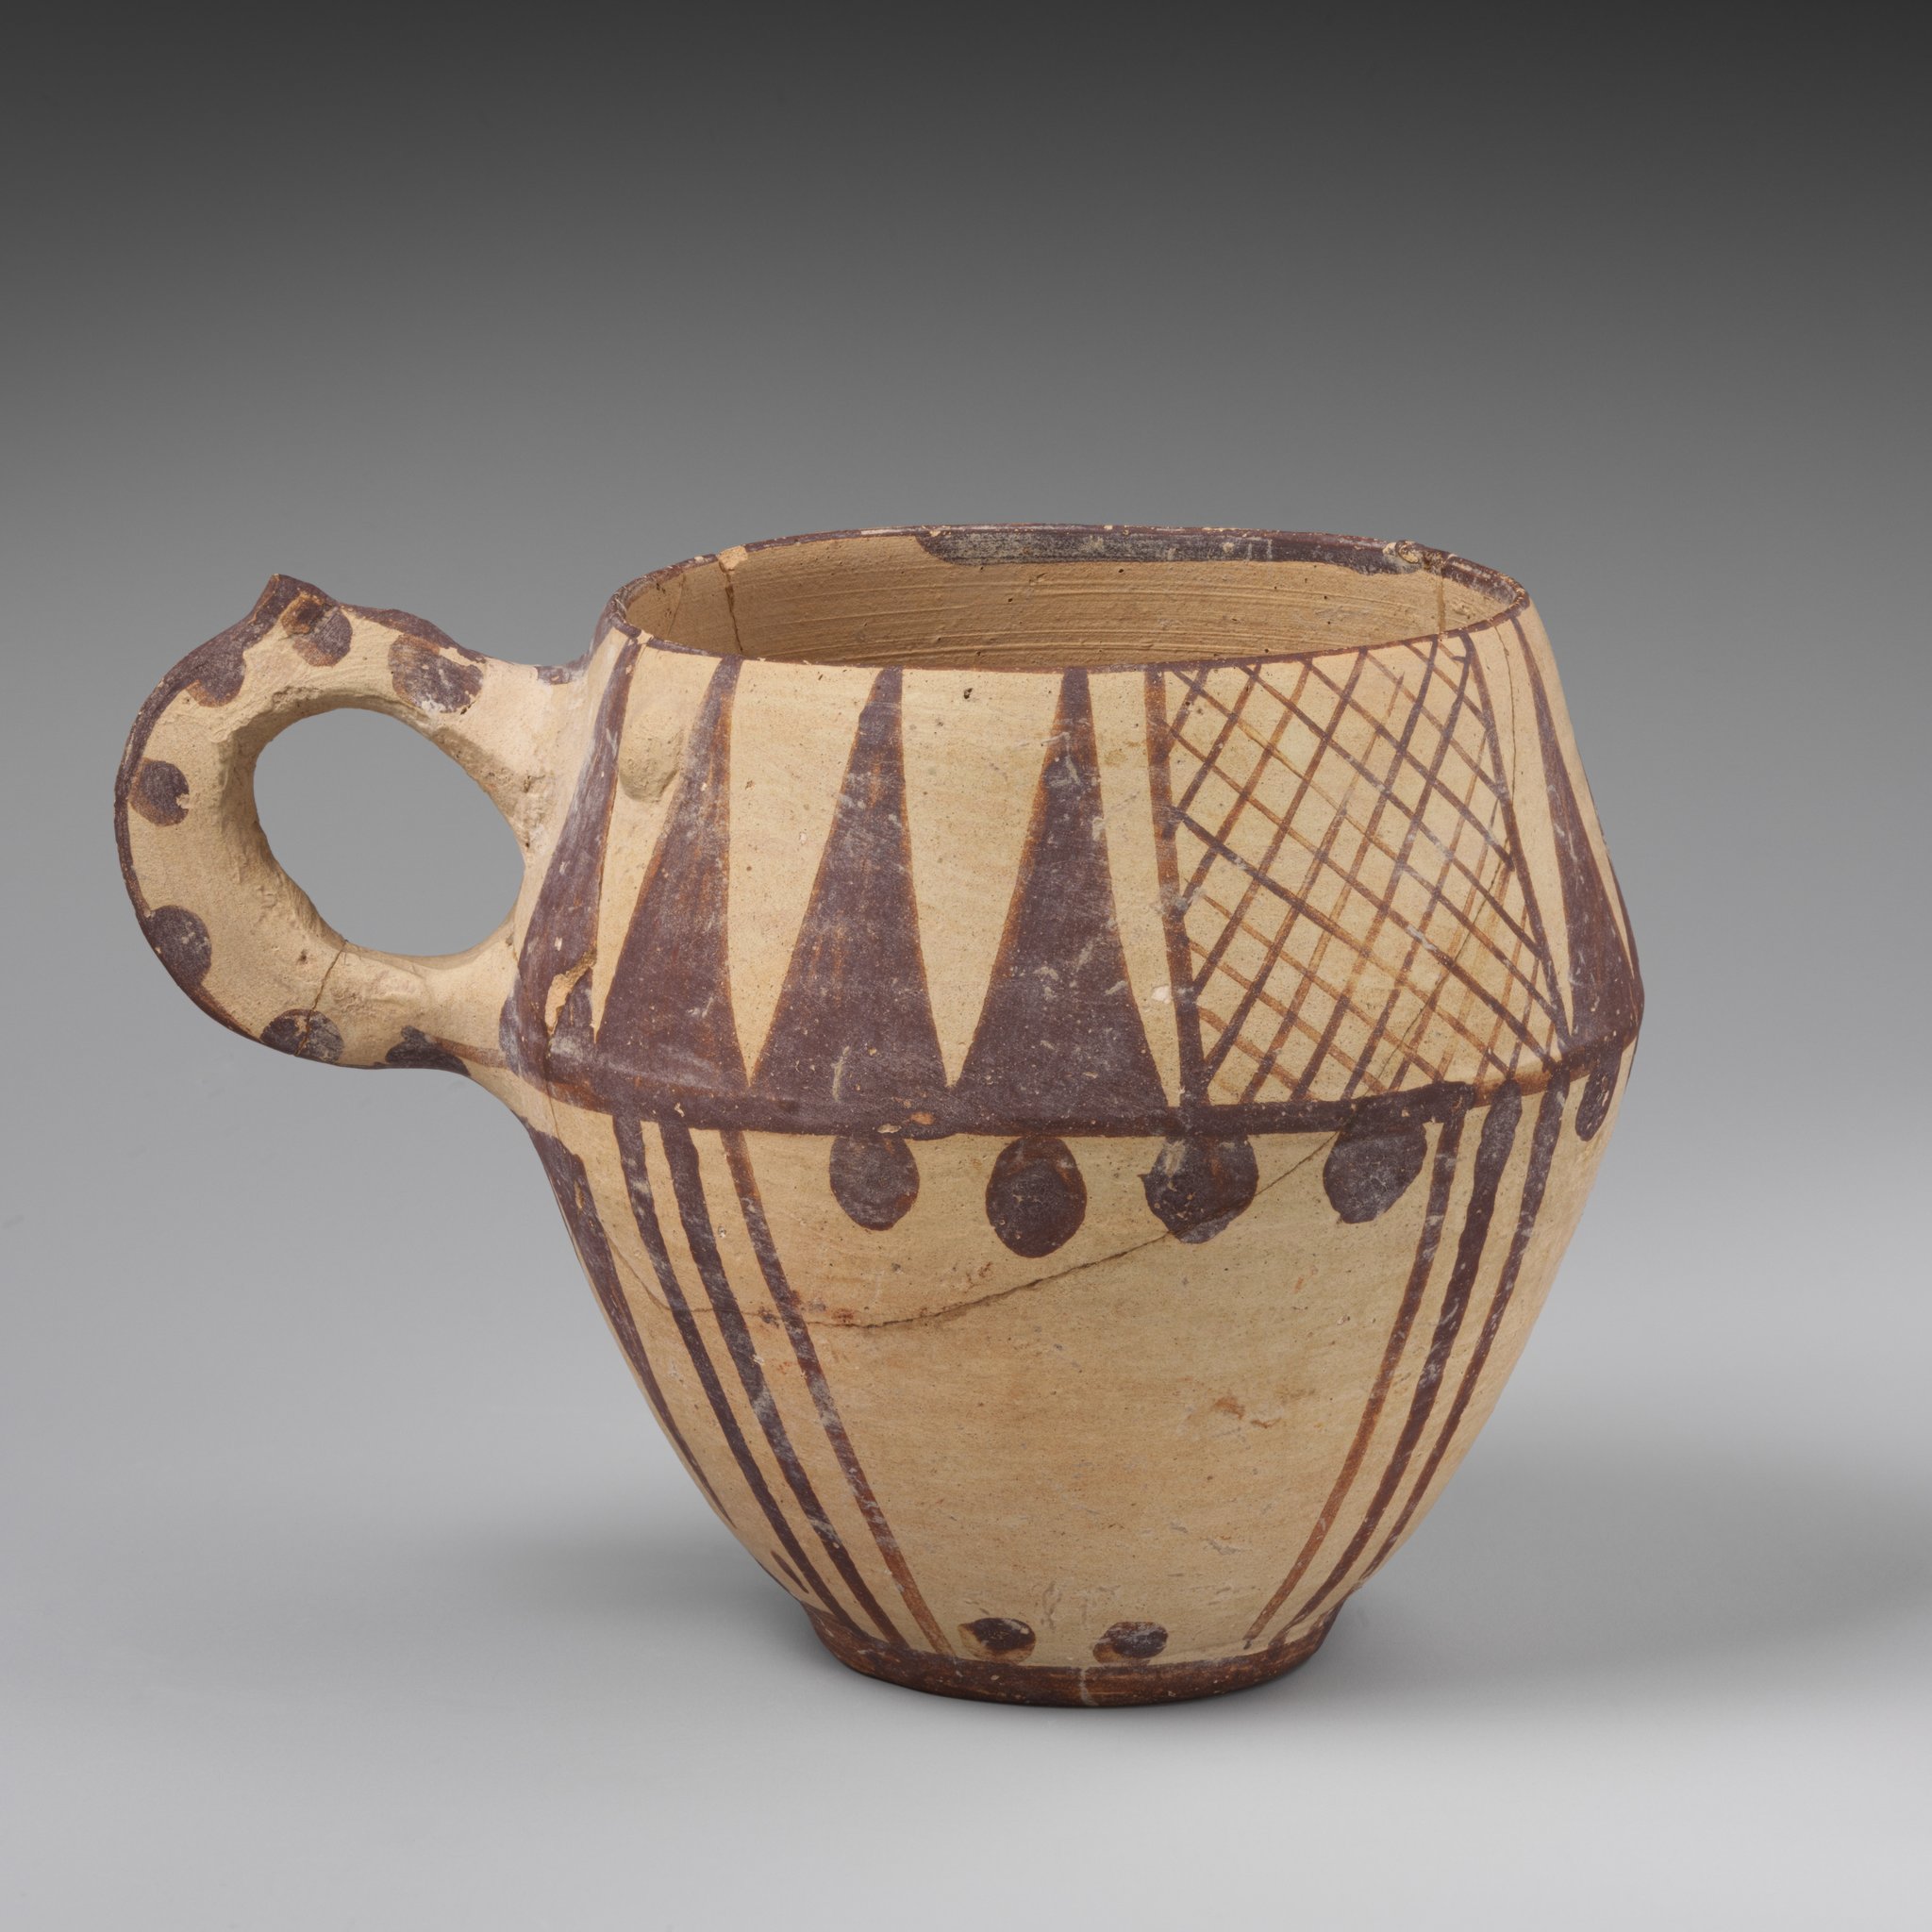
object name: cup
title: One-handled cup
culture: iranian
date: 900-700 BCE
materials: ceramic, paint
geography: iran